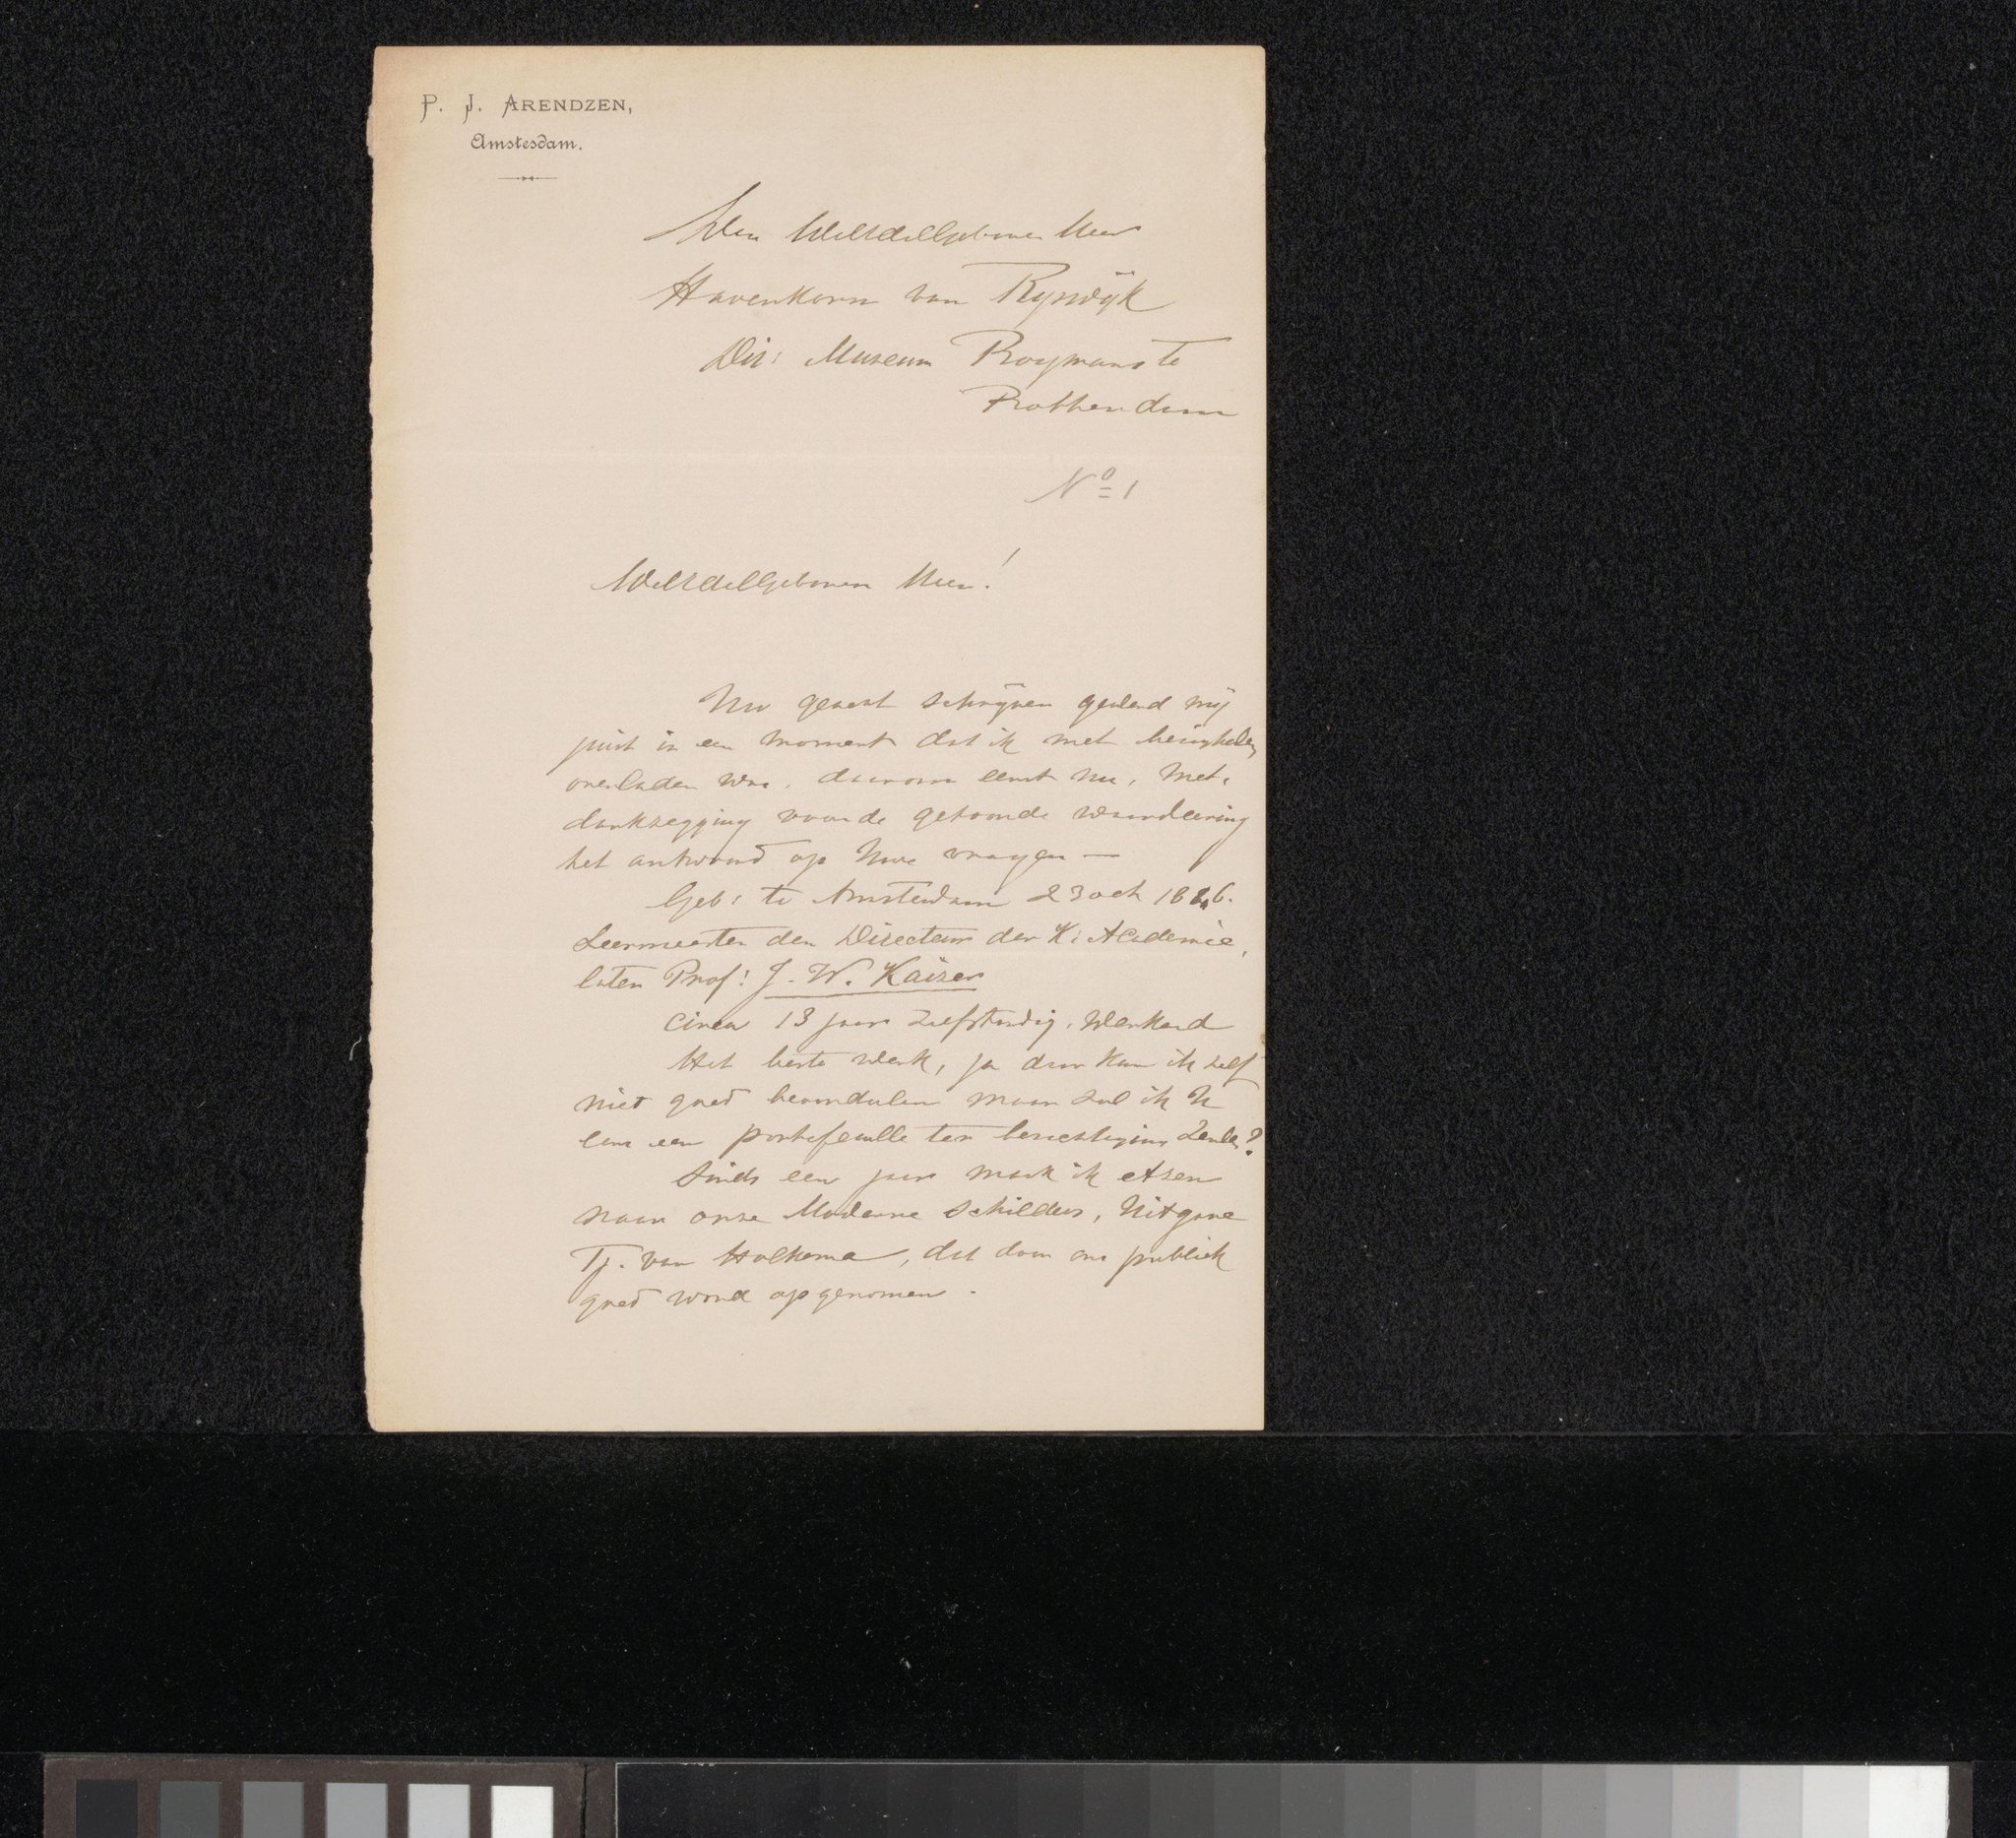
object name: letter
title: Brief aan Pieter Haverkorn van Rijsewijk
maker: petrus johannes arendzen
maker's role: draughtsman, print maker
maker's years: 1846-1932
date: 1884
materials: ink, paper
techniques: pen, printing, writing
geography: amsterdam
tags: publisher, tjomme van holkema, pieter haverkorn van rijsewijk, leiden, print maker, draughtsman, johann wilhelm kaiser (i), the graphic arts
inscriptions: collector's mark: Lugt 2233